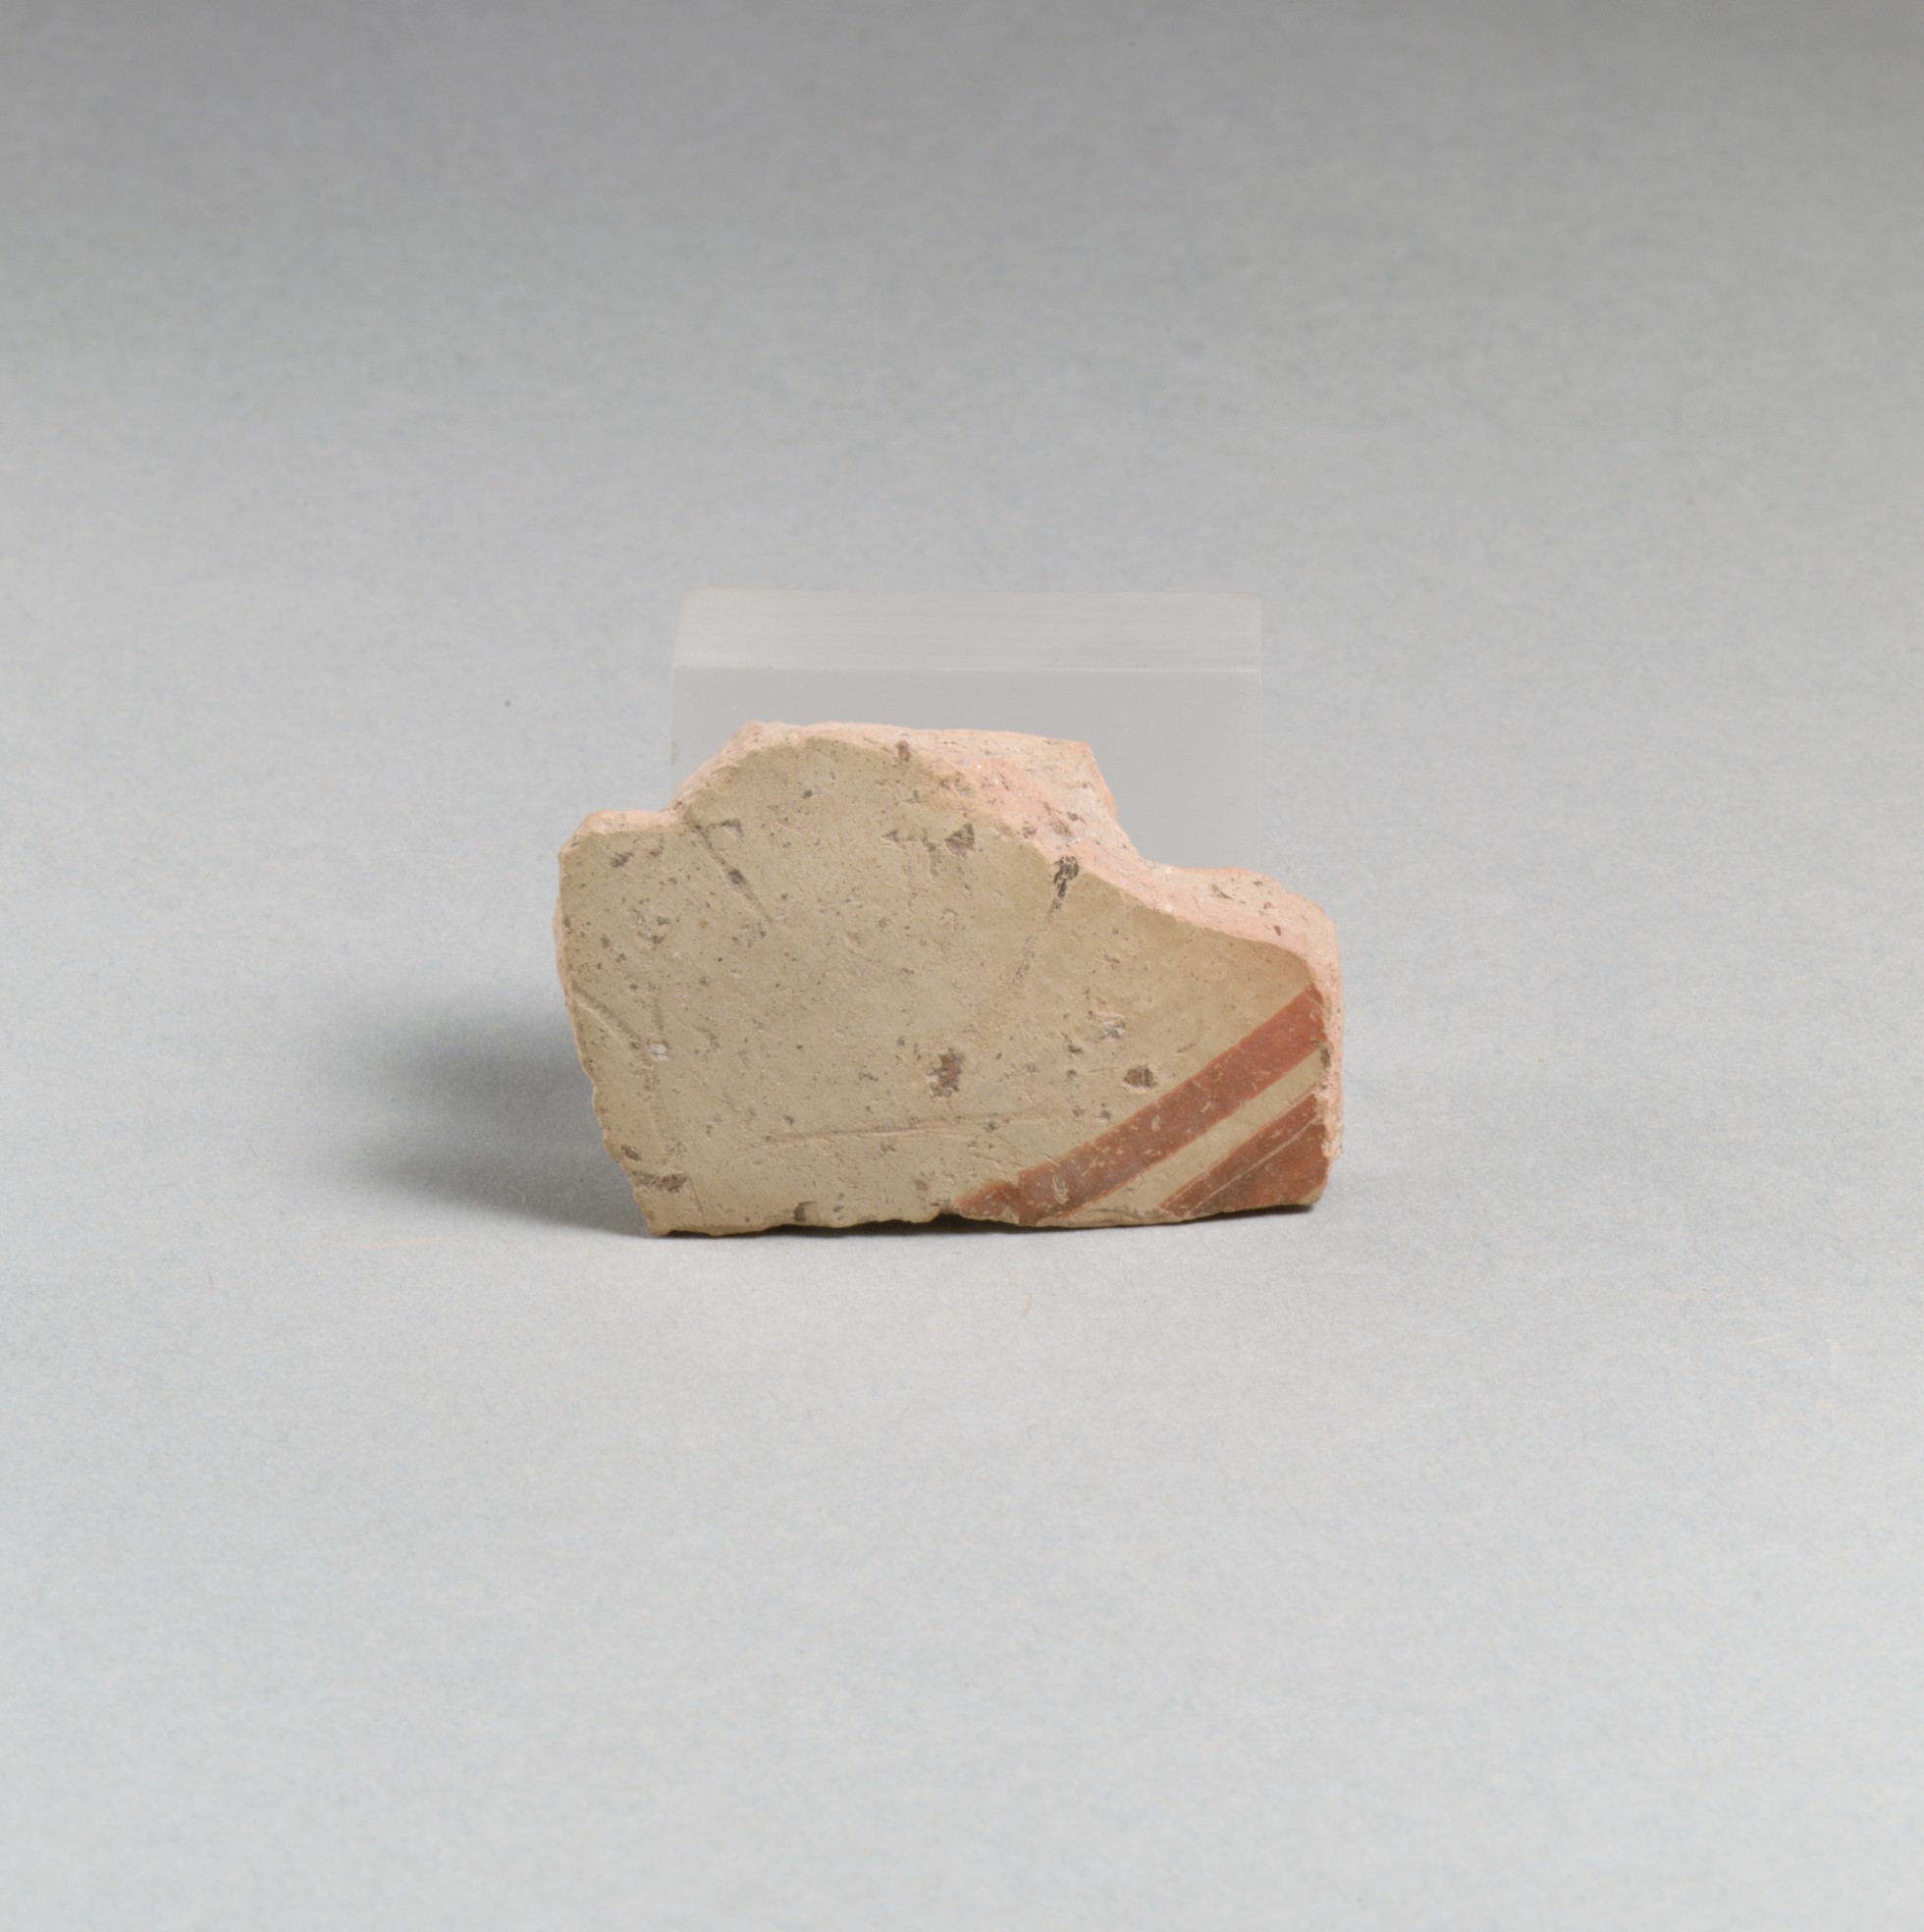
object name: vase fragment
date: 3000-2200 BCE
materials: terracotta